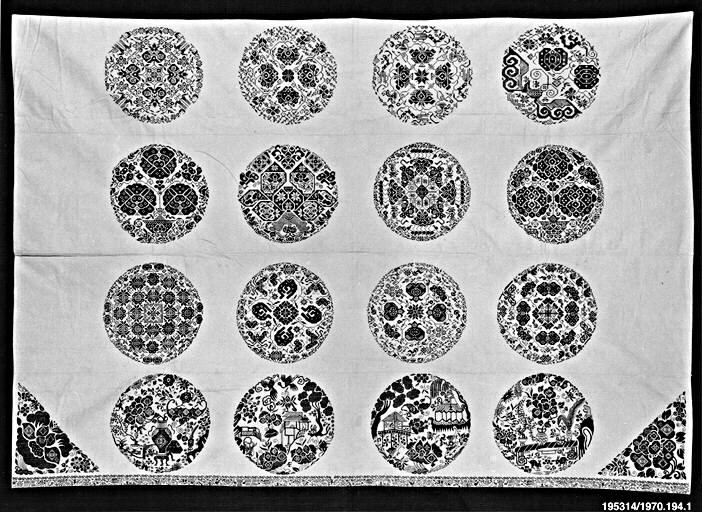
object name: panel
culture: chinese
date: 1801-1900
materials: cotton, linen